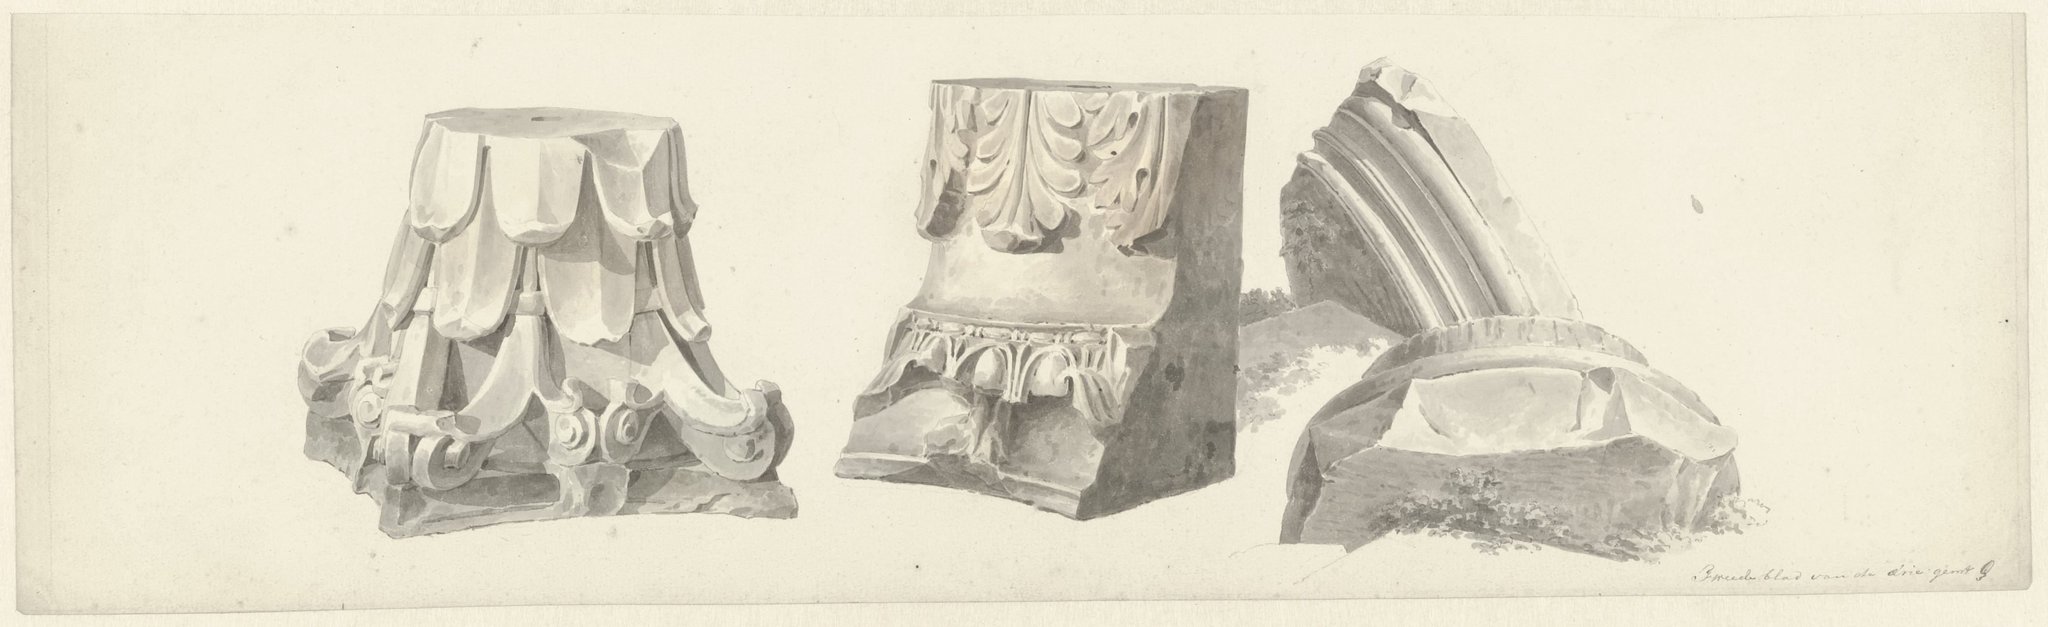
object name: drawing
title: Three Capitals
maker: josephus augustus knip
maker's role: draughtsman, painter, print maker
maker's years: 1777-1847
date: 1809-1812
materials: graphite, paper, watercolor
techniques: brush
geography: italy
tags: capital (~ column, pillar), italy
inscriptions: inscription: ‘Tweede blad van de drie gemt. Q’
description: Originally, these two drawings were the lower halves of the two sheets on the right with a panoramic view of the Baths of Caracalla. The view continues in the drawing on the far right. To indicate that the sheets belonged together, Knip marked them with a capital Q. Who cut two of the three drawings in half and why he did so remains unclear.